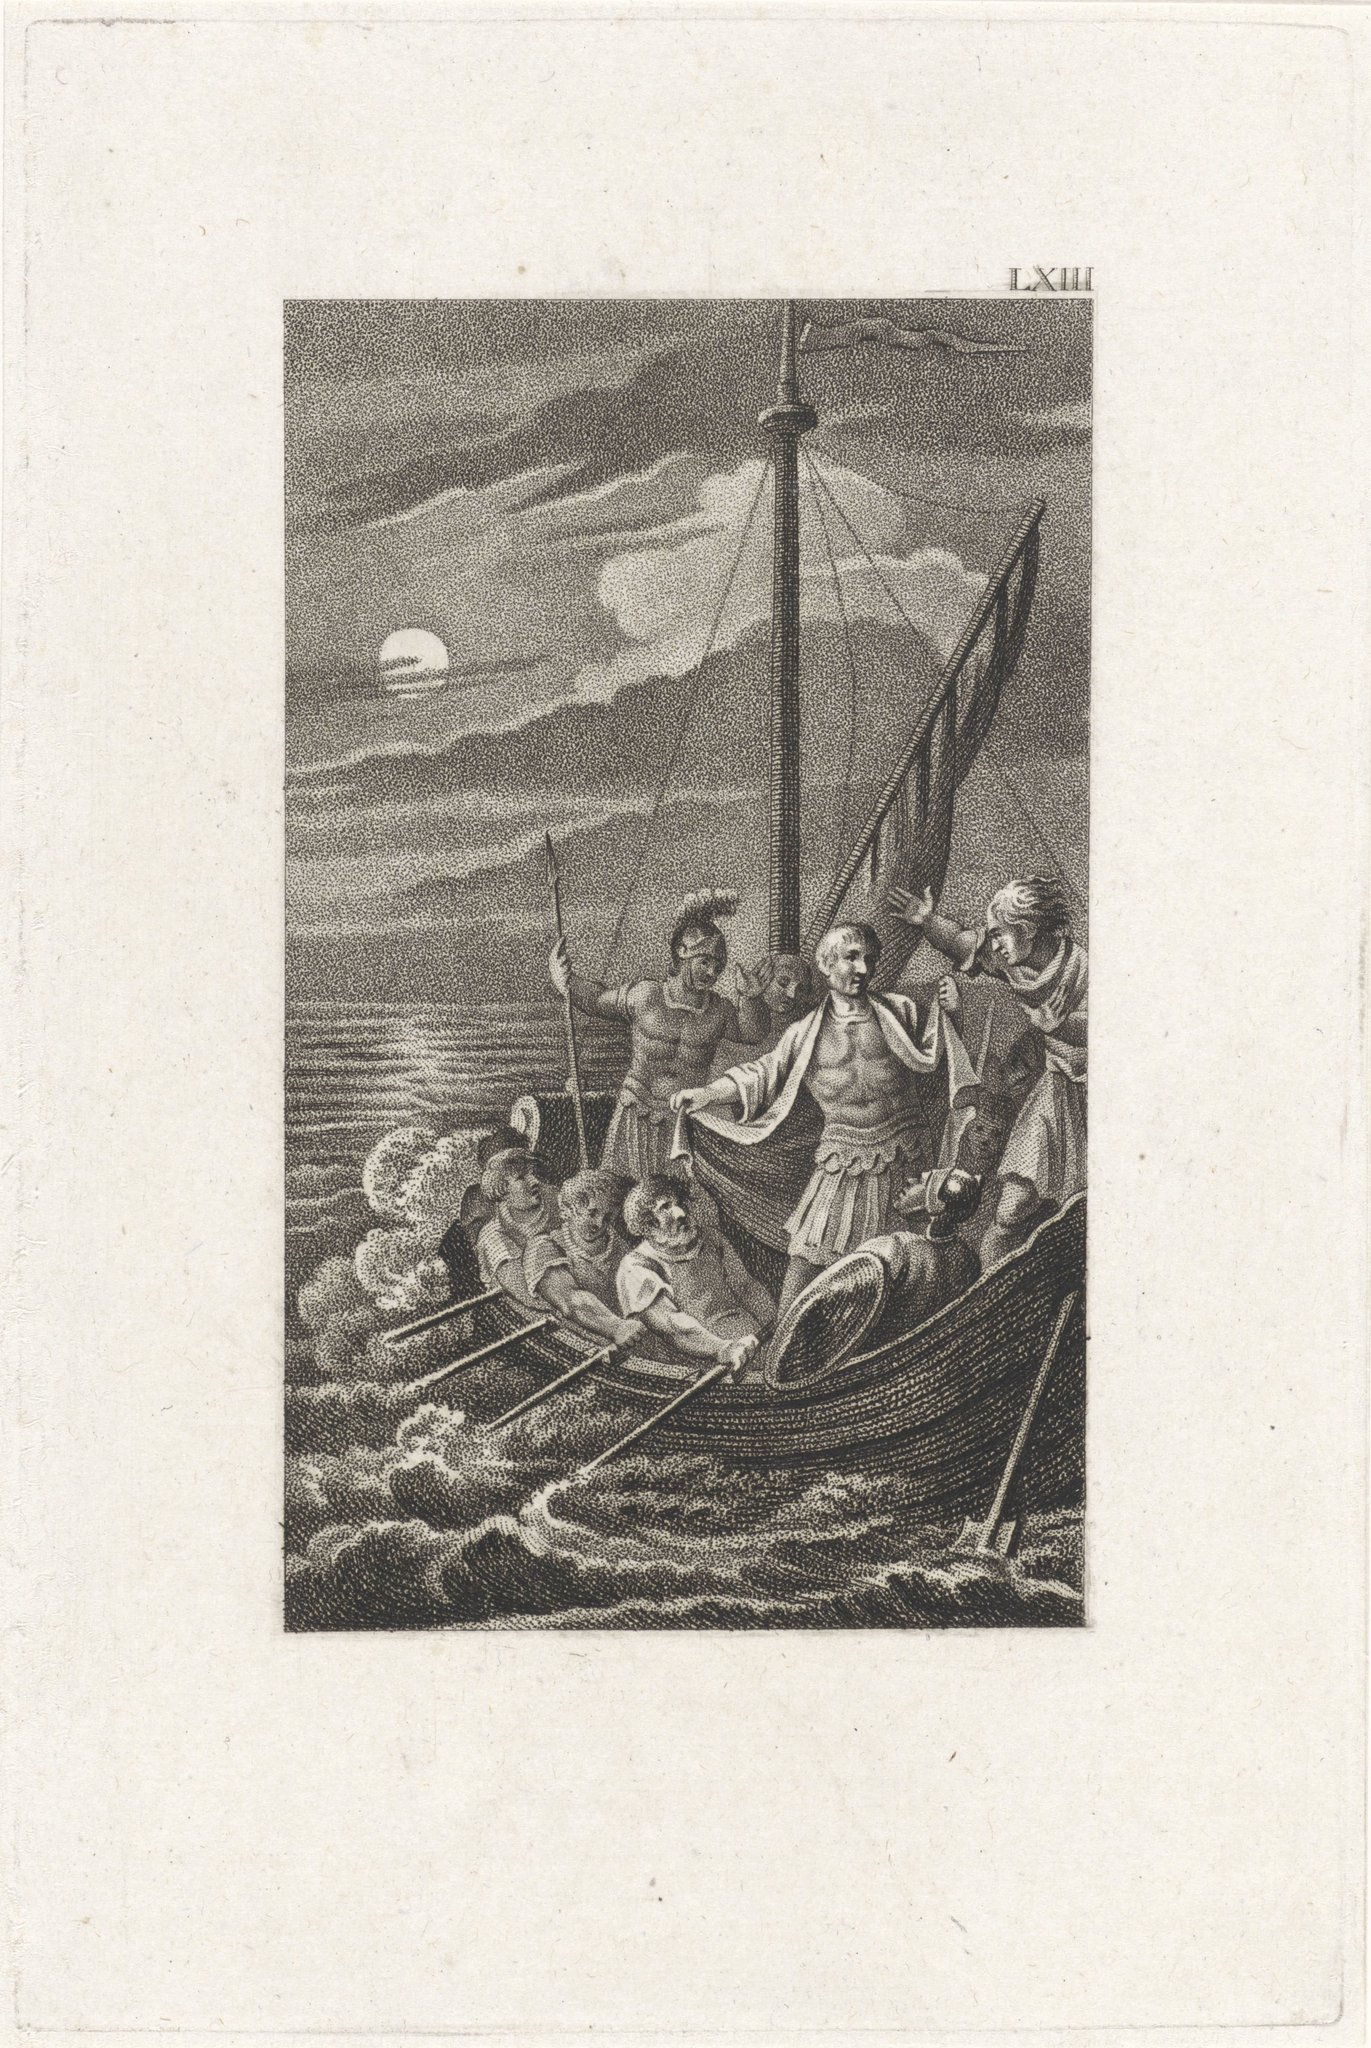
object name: print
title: Caesar haalt zijn krijgsmacht uit Italië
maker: ludwig gottlieb portman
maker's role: print maker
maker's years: 1772-1828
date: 1800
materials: paper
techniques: etching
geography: amsterdam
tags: slavery; serfs and enslaved persons, non-aggressive activities of c. julius caesar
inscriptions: collector's mark: Lugt 2228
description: De manschappen van Caesar worden per schip weggevoerd uit Italië. Caesar, vermomd als slaafgemaakte man, staat te midden van zijn soldaten op het schip.